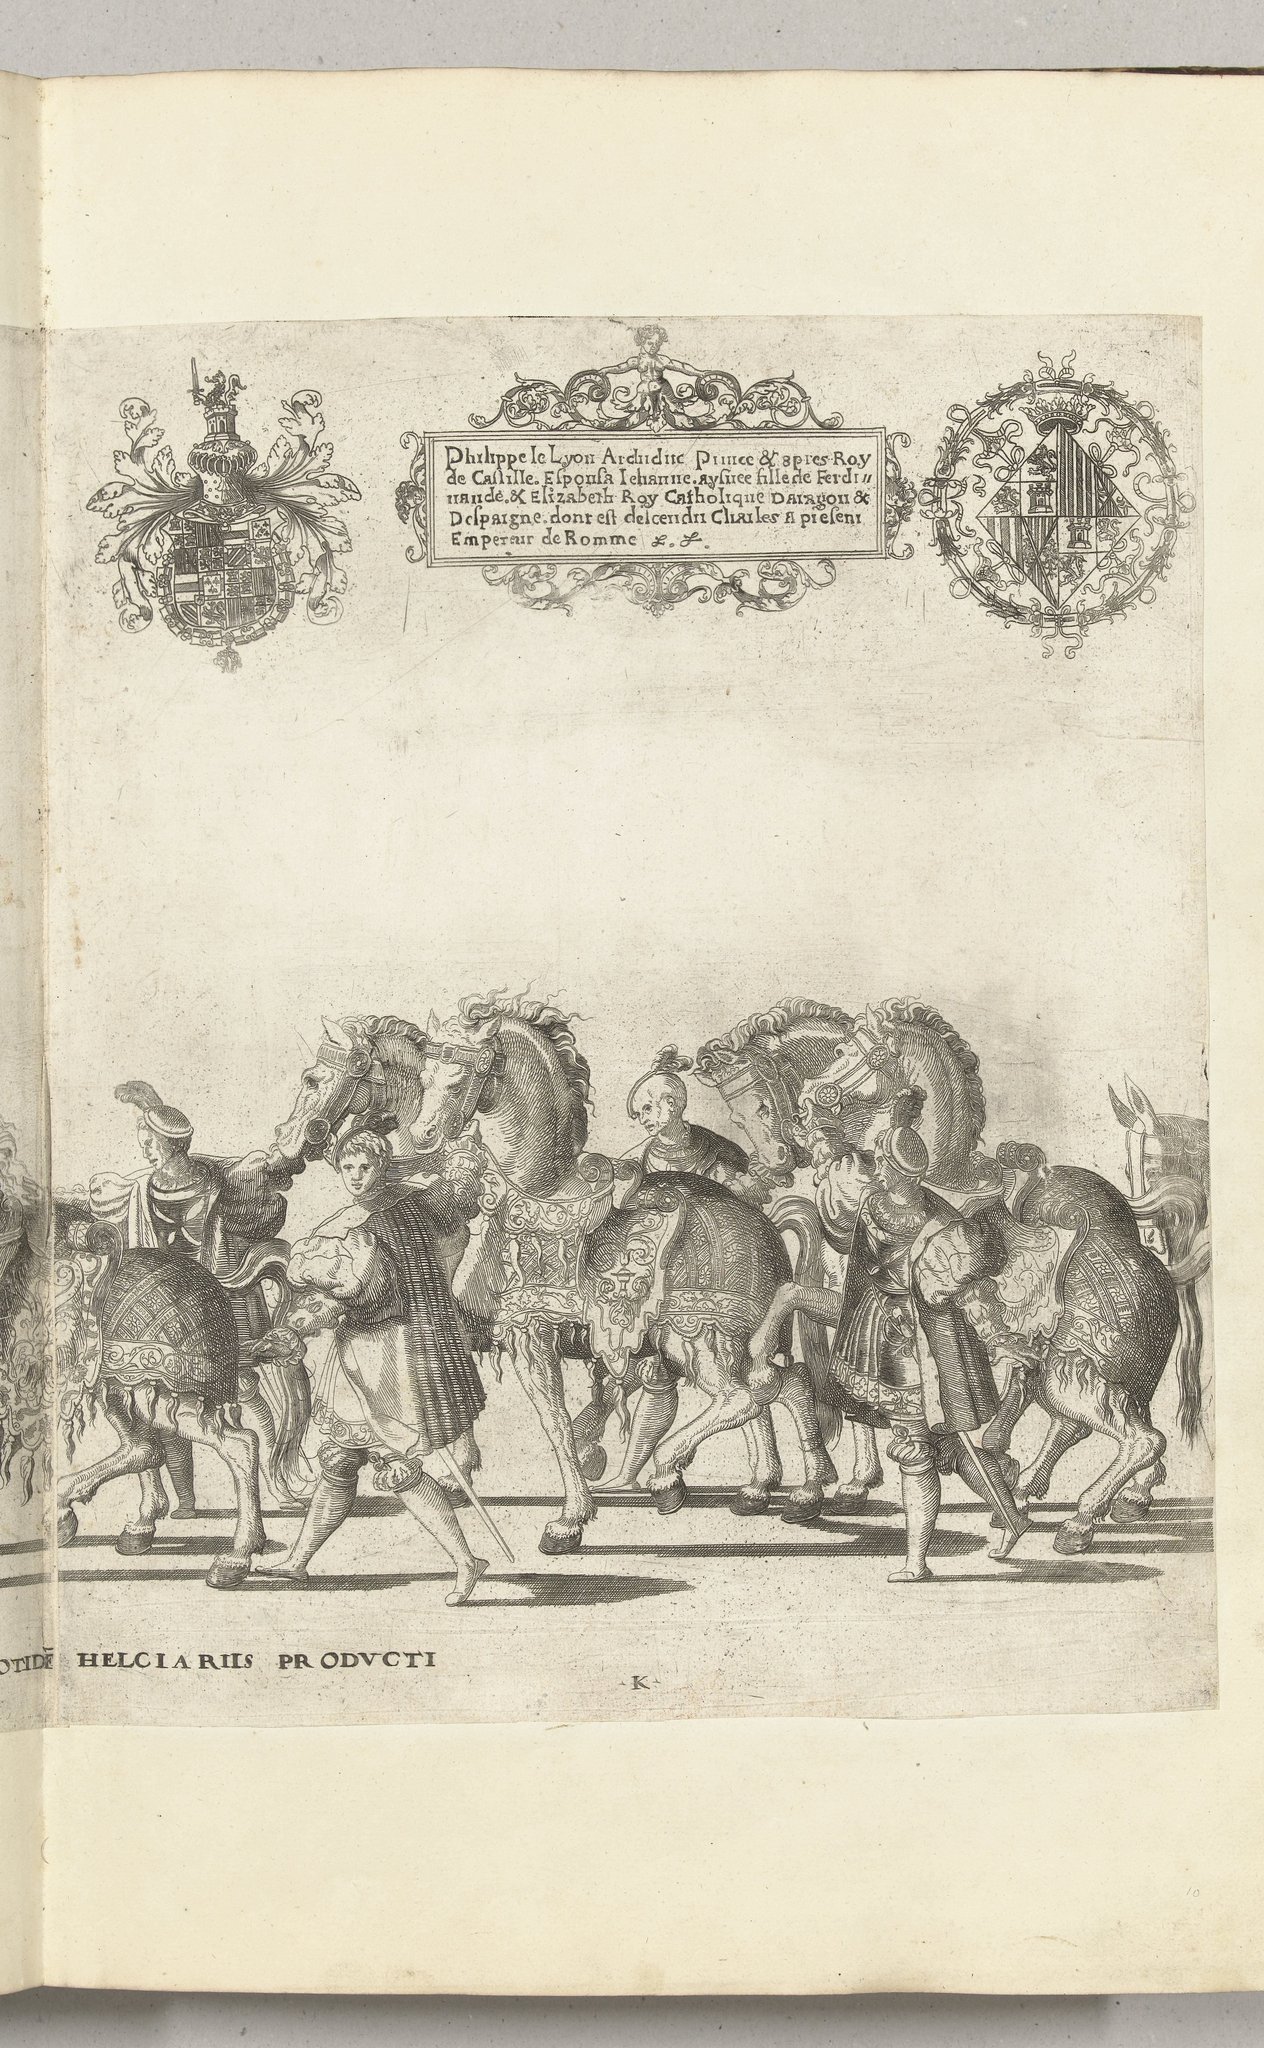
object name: propagandaprent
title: Voetknechten met paarden, plaat K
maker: nicolaas hogenberg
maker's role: draughtsman, painter, print maker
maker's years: 1500-1539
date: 1530-1536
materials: paper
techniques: etching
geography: mechelen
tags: ghent, charles v (holy roman emperor and king of spain), festivities (+ parade, pageant, cavalcade ~ festive activities)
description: Prent in het album waarin zijn ingeplakt de 40 platen die achterelkaar samen het fries vormen van de optocht van Karel V met de paus Clemens VII te Bologna na zijn kroning tot keizer, 24 februari 1530.